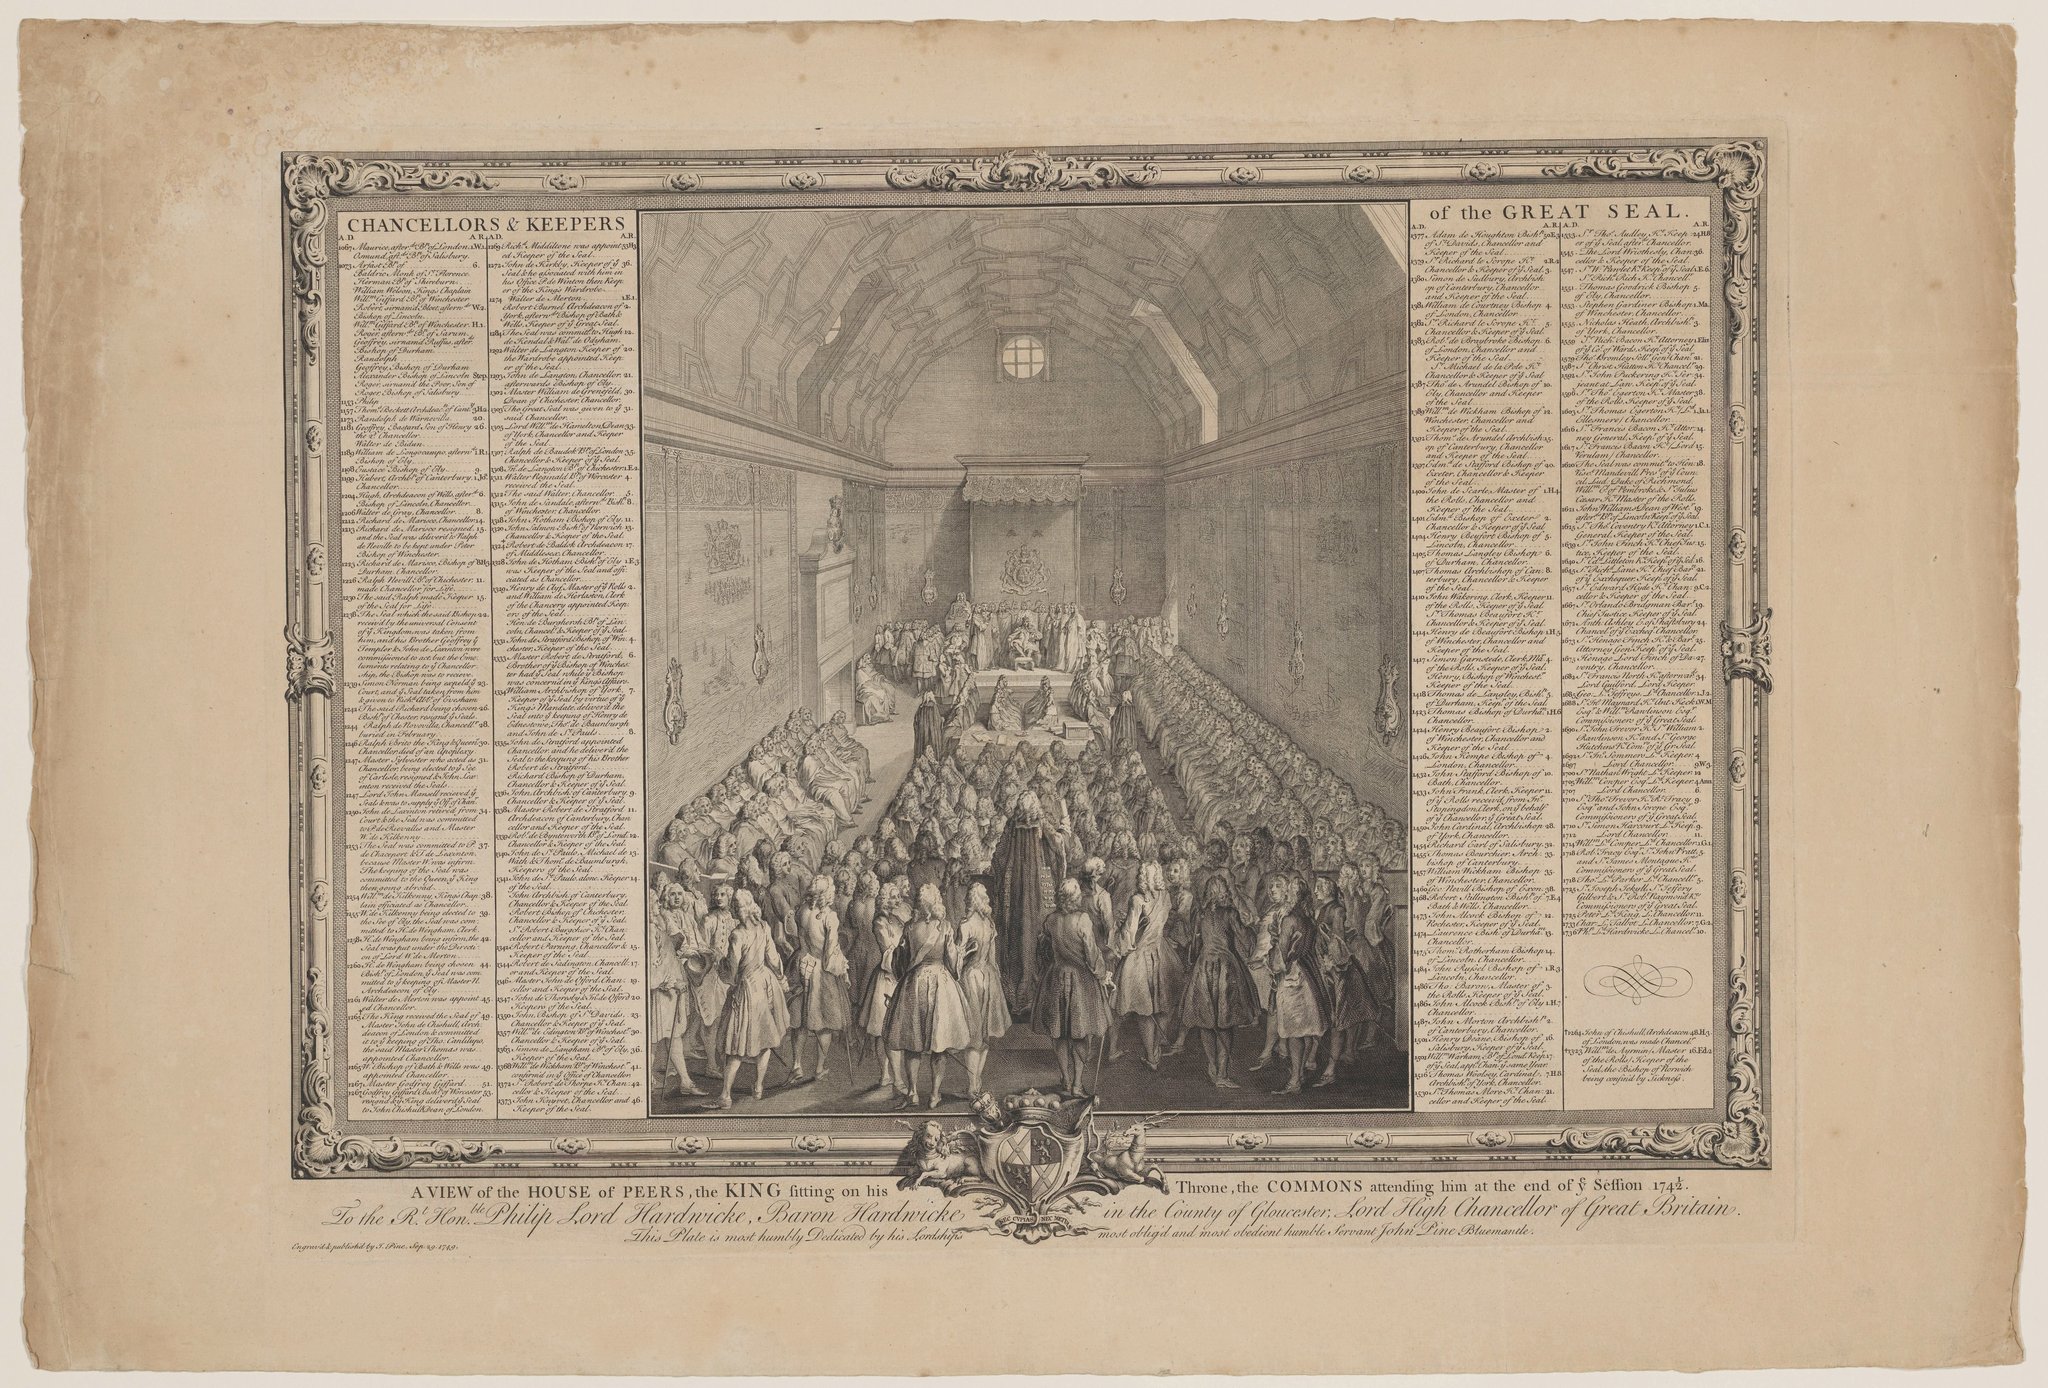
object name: print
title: Britse Hogerhuis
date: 1749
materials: paper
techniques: engraving, etching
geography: london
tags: upper house, senate, london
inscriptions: collector's mark: Lugt 2228, inscription: ‘chambre pairs, chambre de communes, green-dale-oaxe’